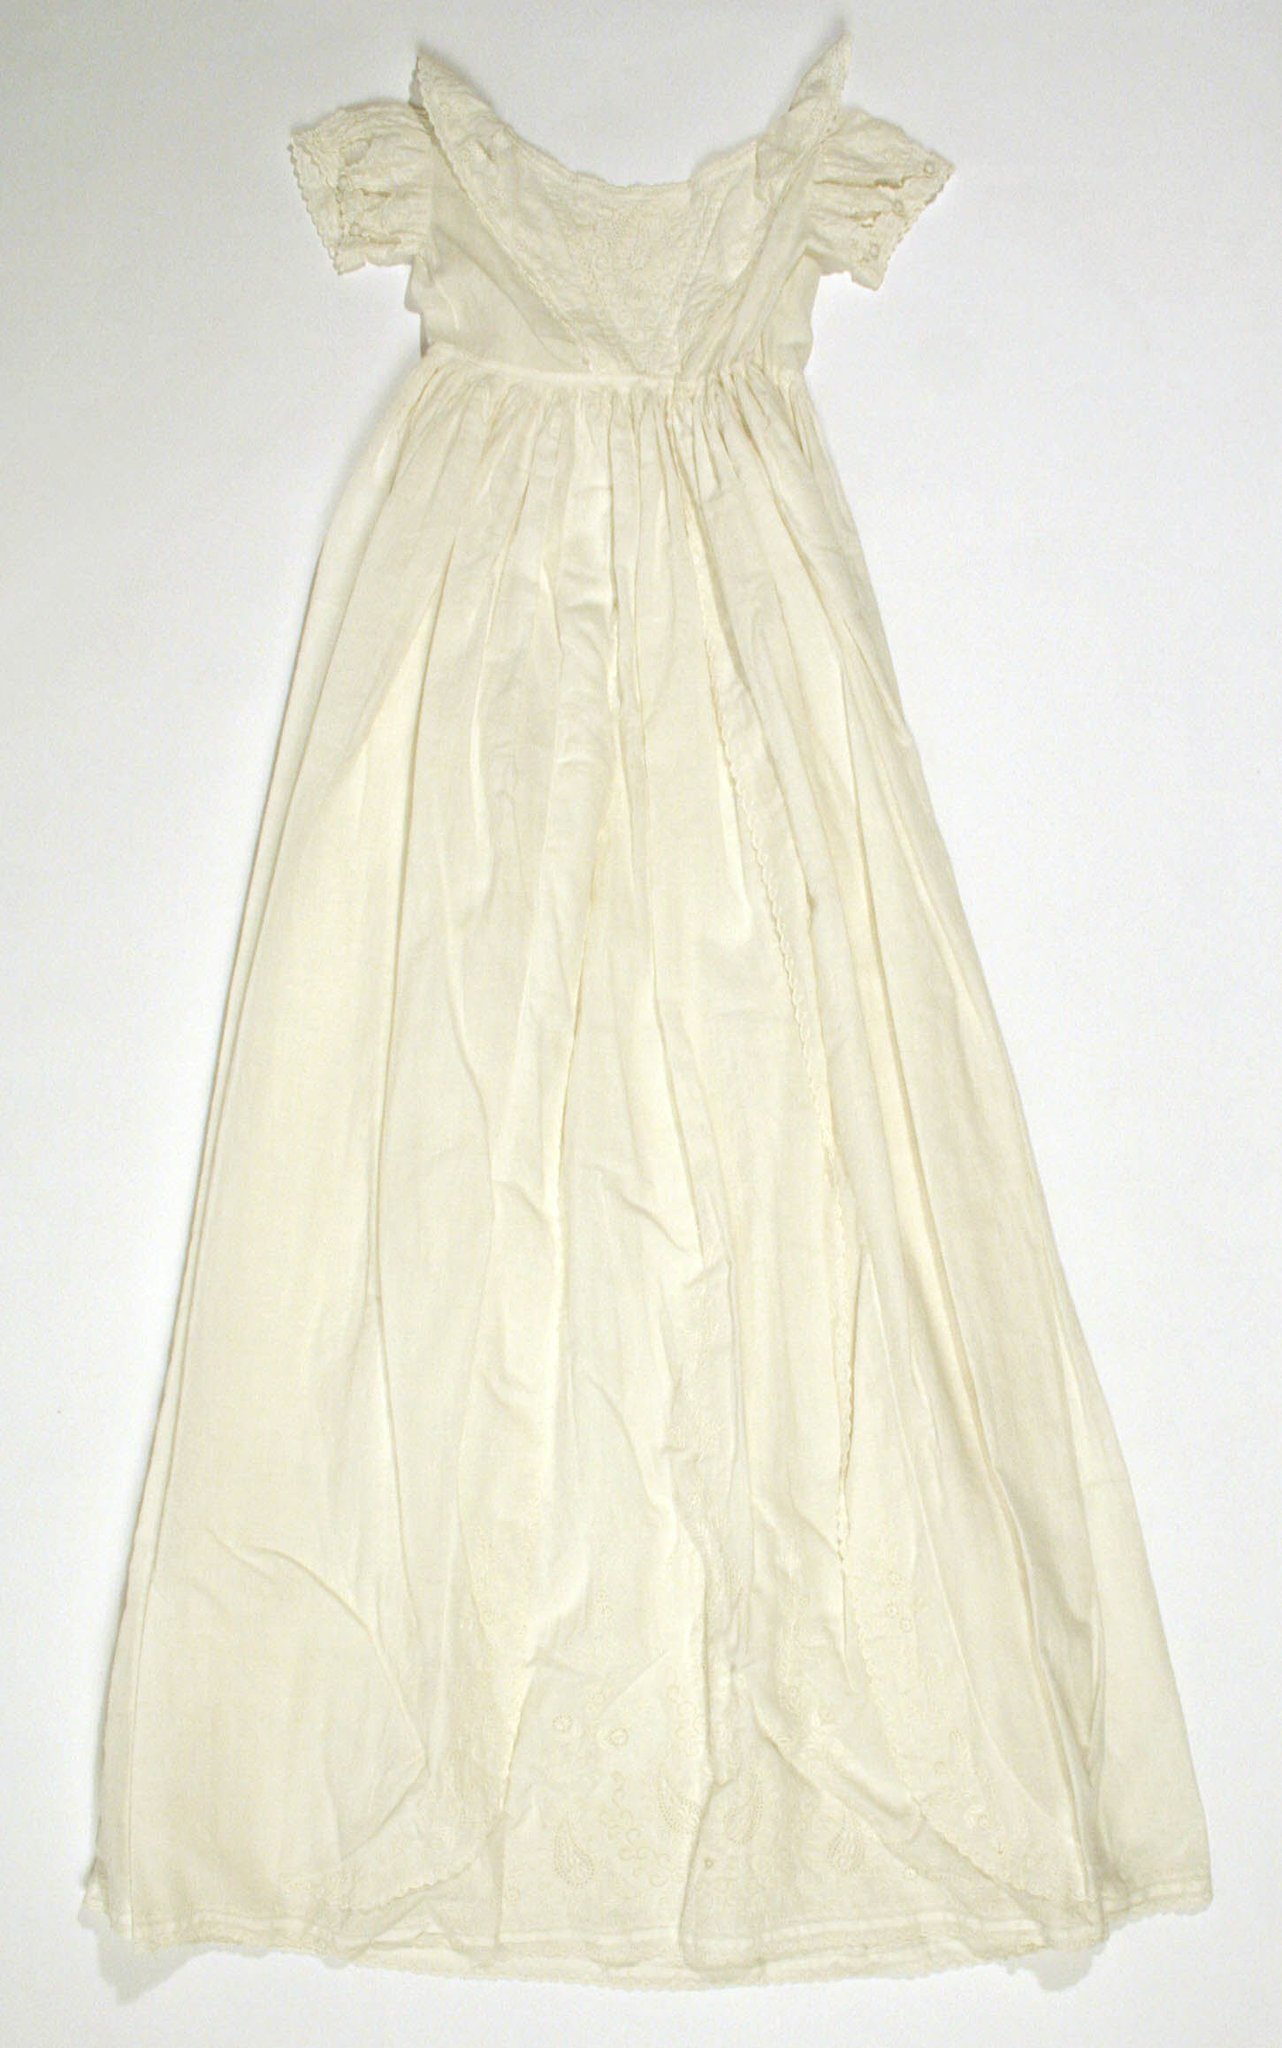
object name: christening dress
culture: american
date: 1840-1860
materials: cotton